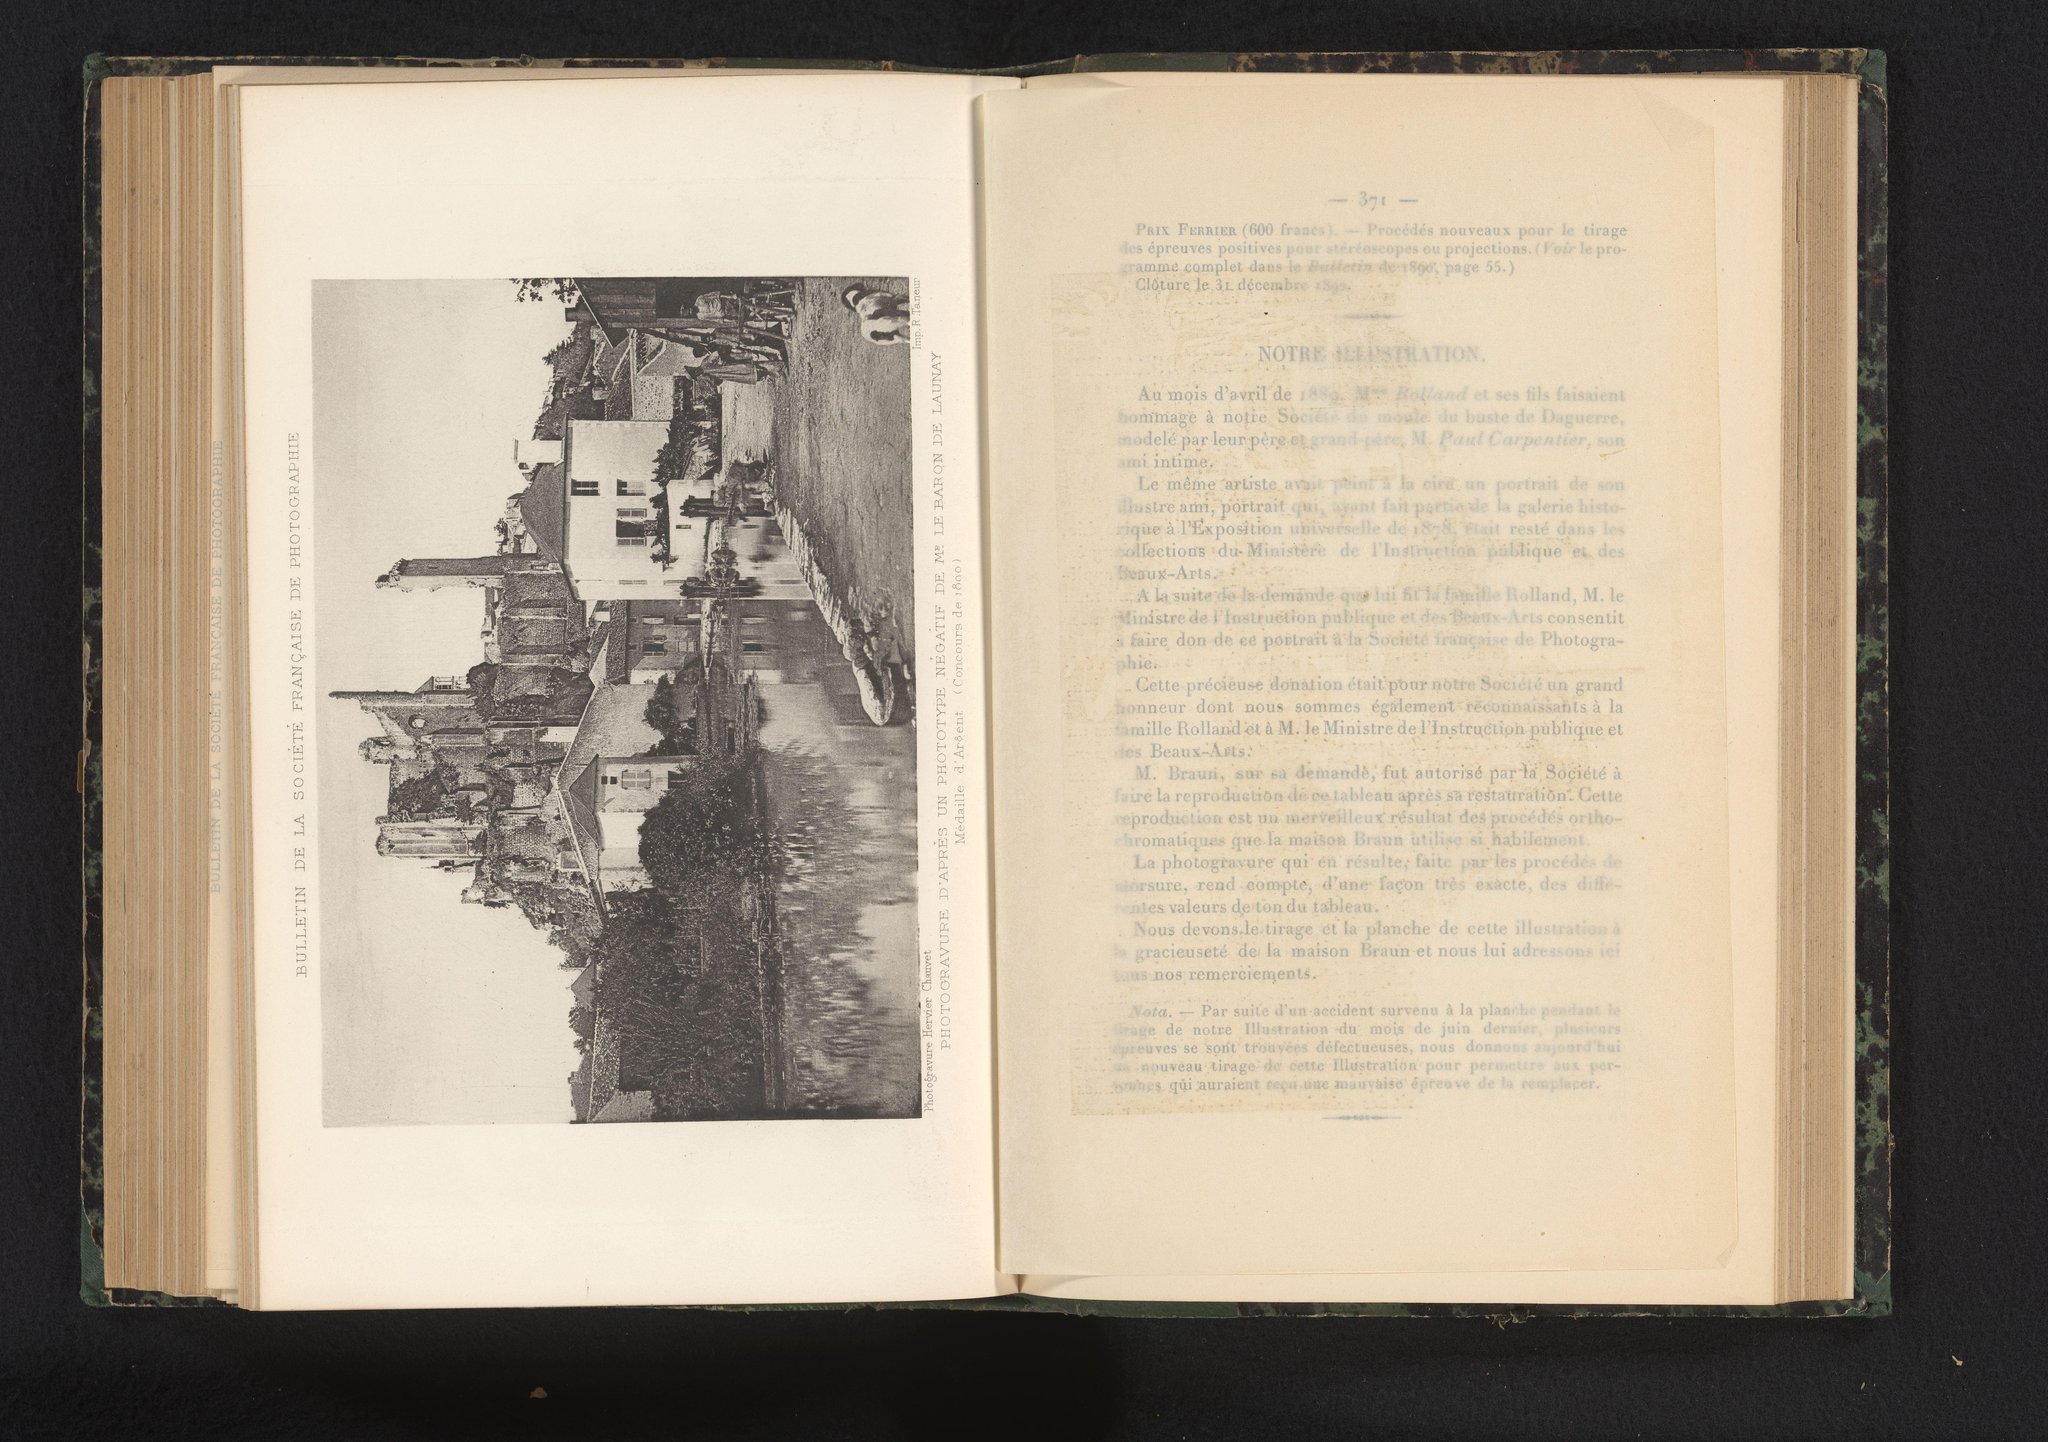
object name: photomechanical print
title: Château de Chantilly, gezien vanaf de tuinzijde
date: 1886-1891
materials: paper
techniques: photograph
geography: nancy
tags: castle